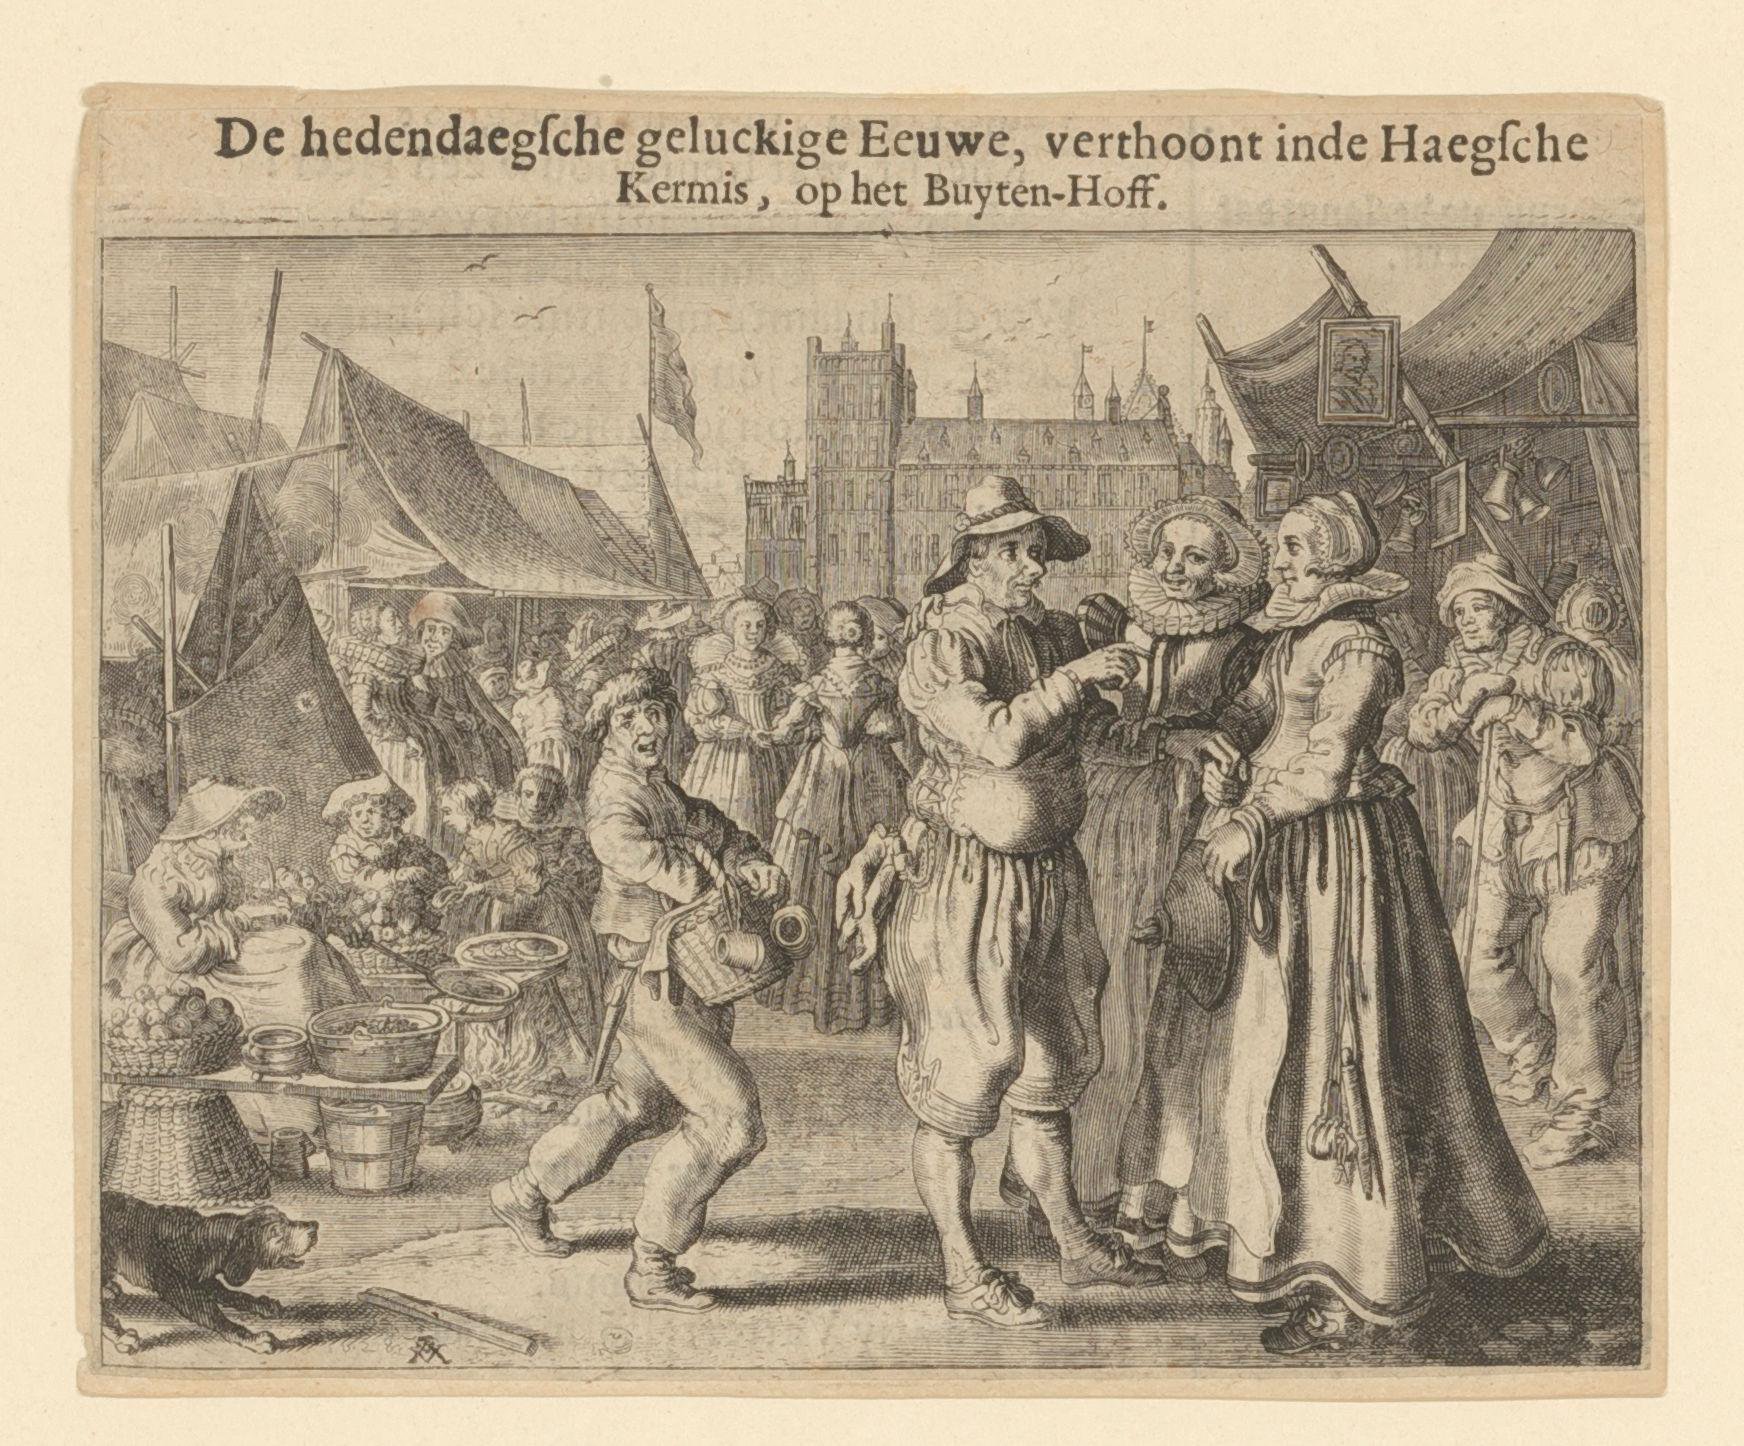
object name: print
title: Markt op het Buitenhof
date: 1635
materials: paper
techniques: engraving, etching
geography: netherlands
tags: pleasure fair and circus, market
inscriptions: collector's mark, collector's mark: Lugt 1641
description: Marktscène op het Buitenhof, tijdens de Haagse Kermis. Rechts Tamme Lubbert sprekend met Fijtje Goris. Op de achterkant bedrukt met tekst. Onderwerpsrubrieken binnen de Atlas Zeden en Gewoonten: Volksfeesten; Kermis.